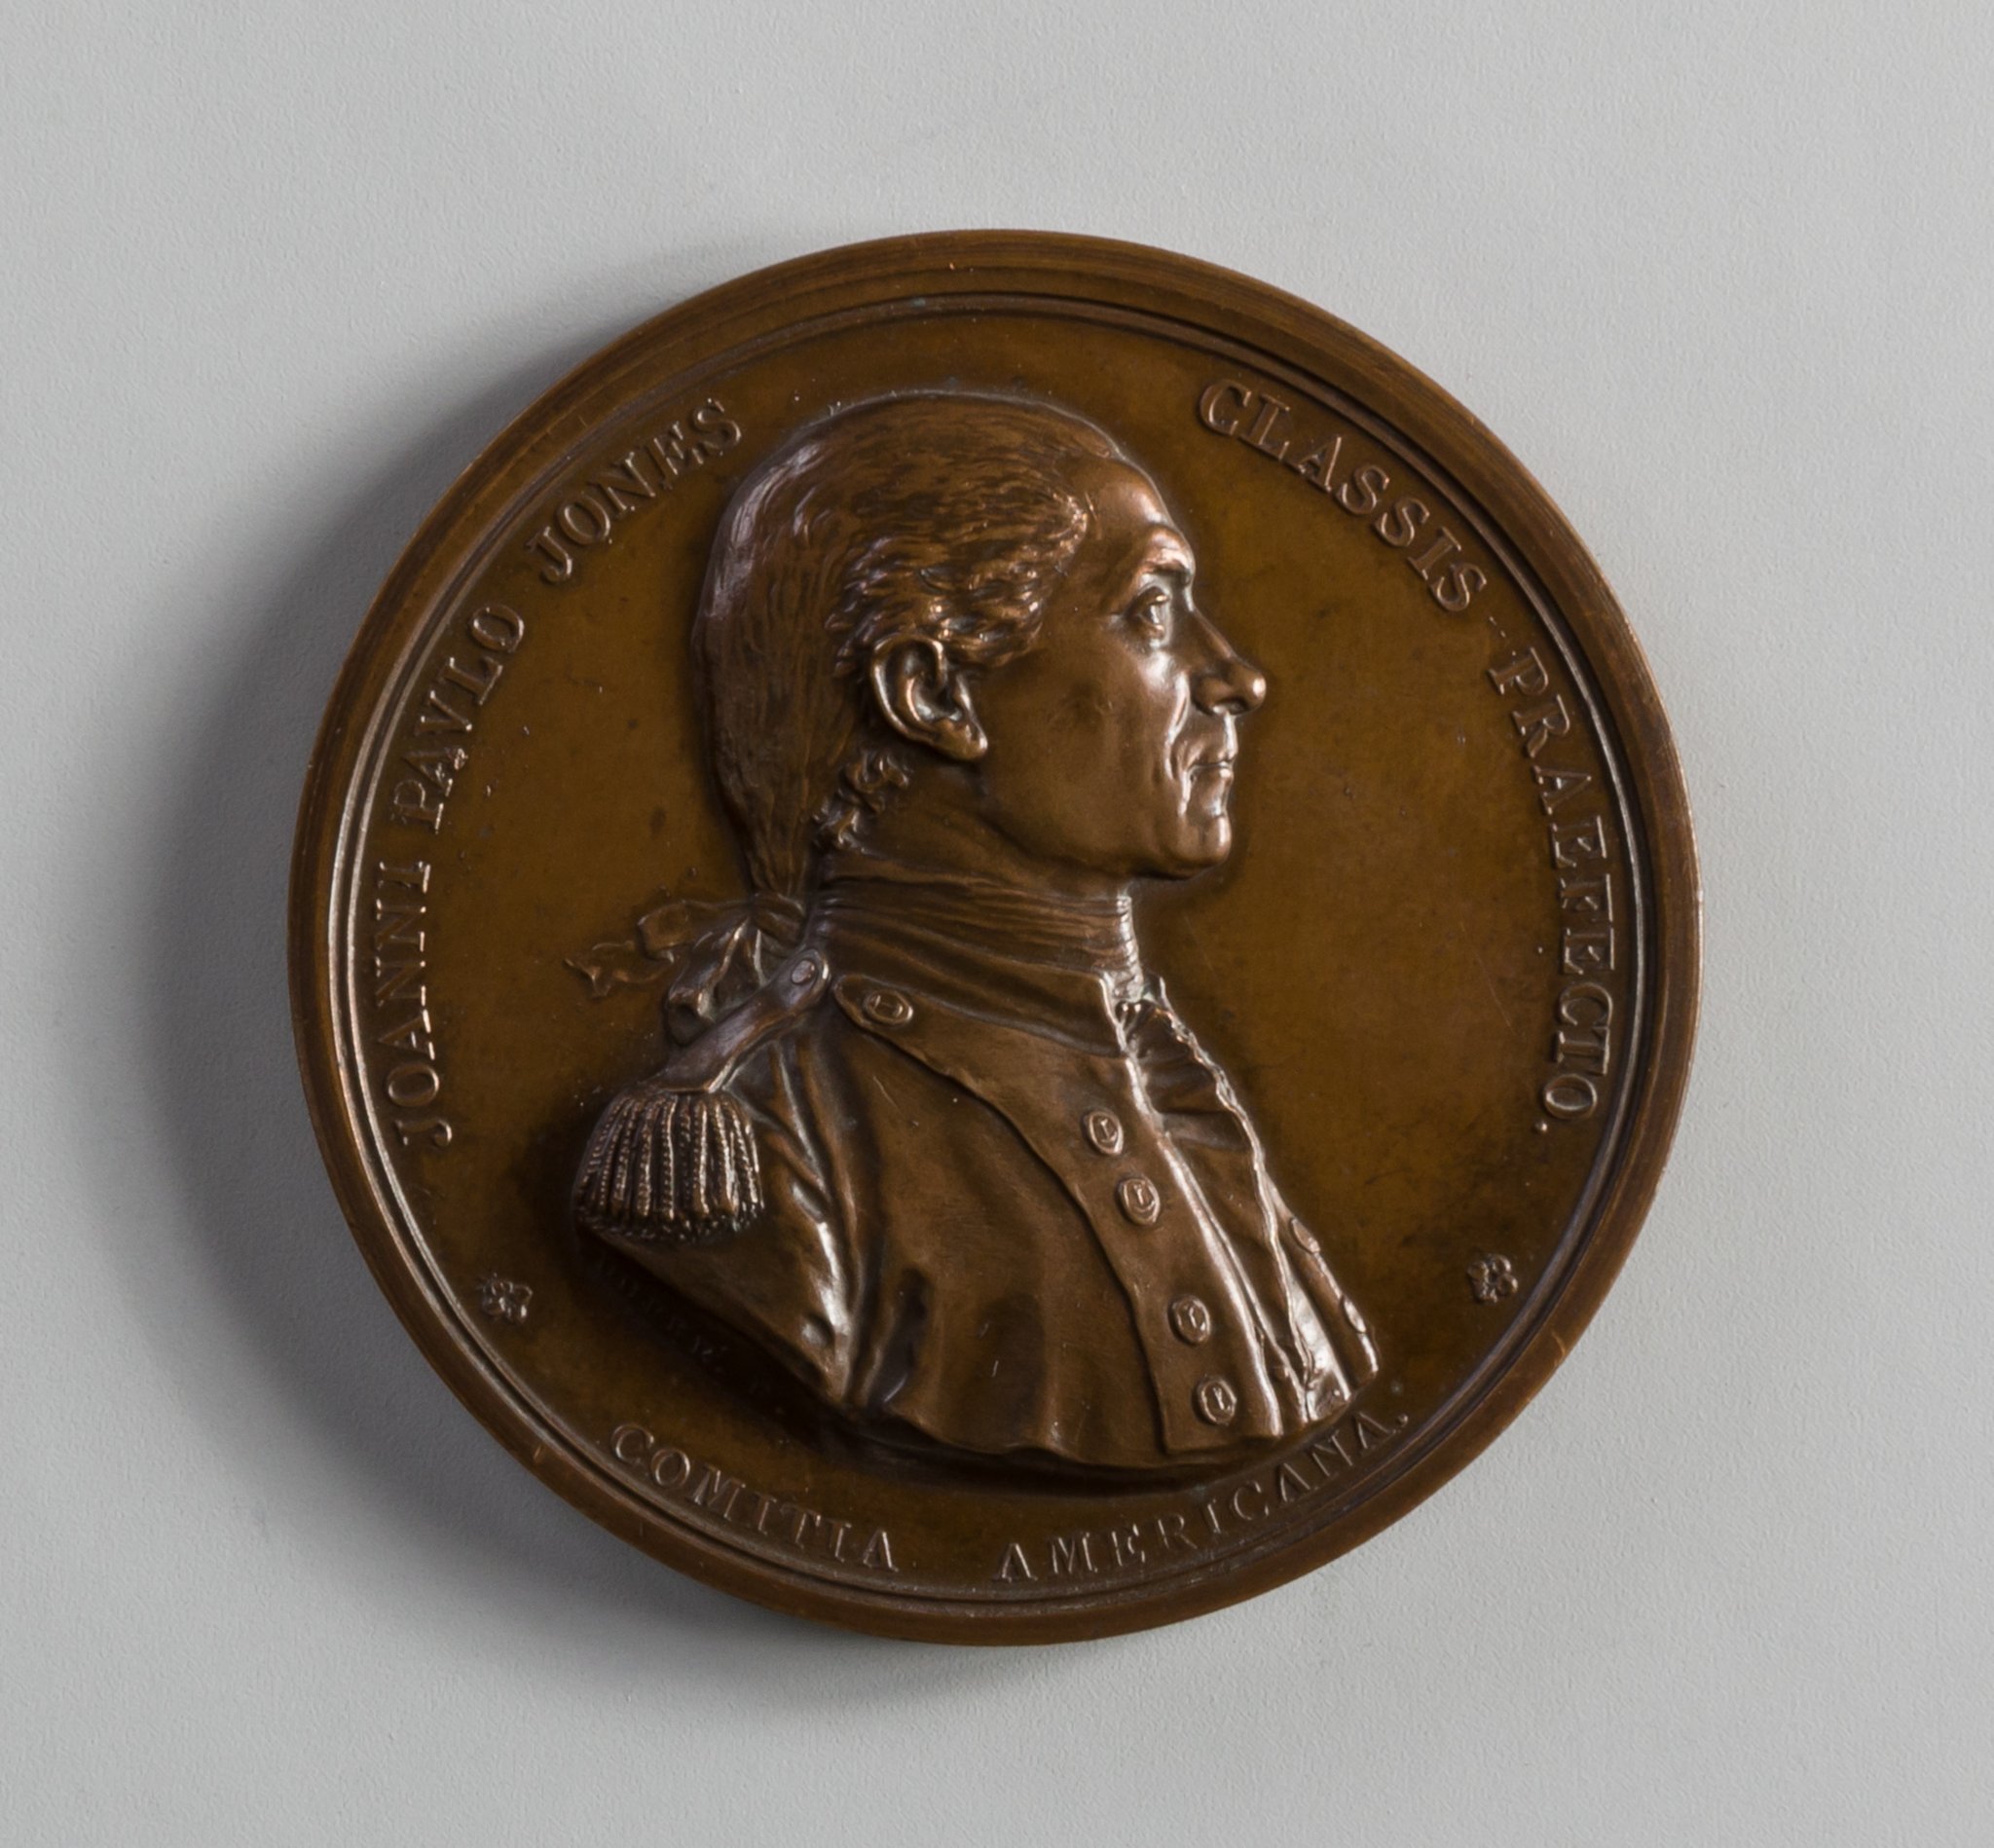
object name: medal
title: Medal of John Paul Jones and the Serapis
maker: augustin dupré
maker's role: maker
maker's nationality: french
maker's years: 1748-1833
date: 1779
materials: copper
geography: france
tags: men,profiles